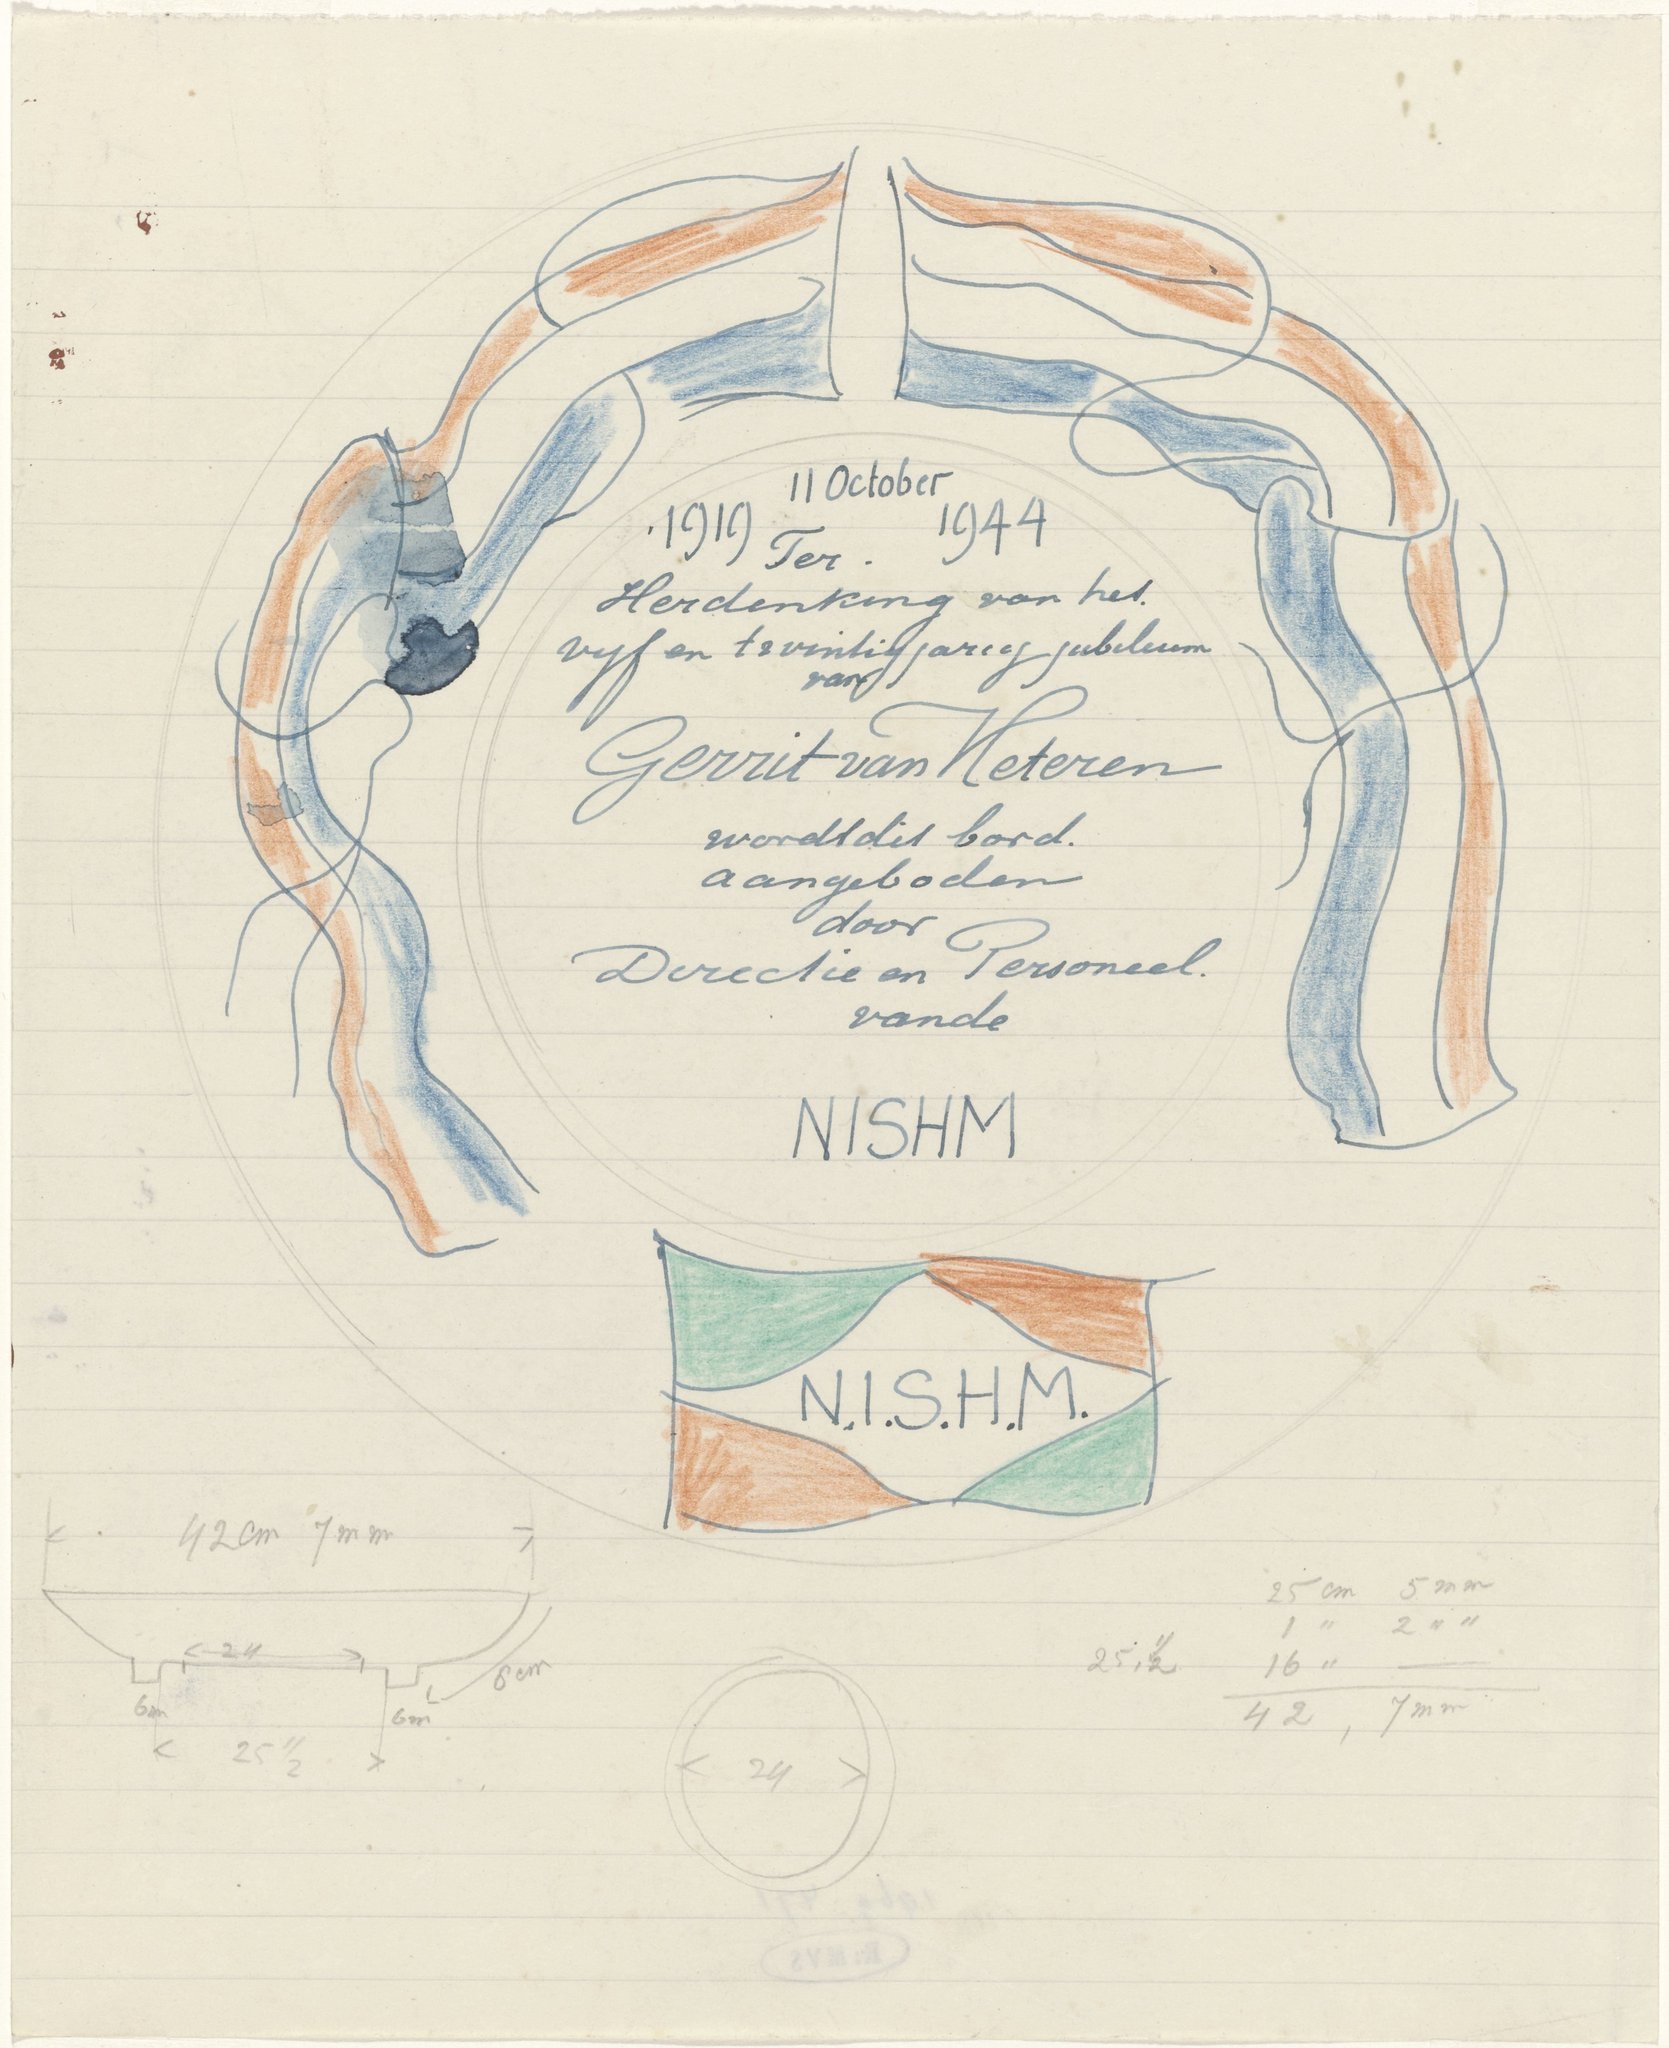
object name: design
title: Ontwerp voor een bord ter gelegenheid van 25-jarig jubileum van Gerrit van Heteren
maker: carel adolph lion cachet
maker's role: draughtsman, print maker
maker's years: 1864-1945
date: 1874-1945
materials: chalk, ink, paper, pencil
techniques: pen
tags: work of applied art (+ ceramics ~ arts), dish, plate, saucer